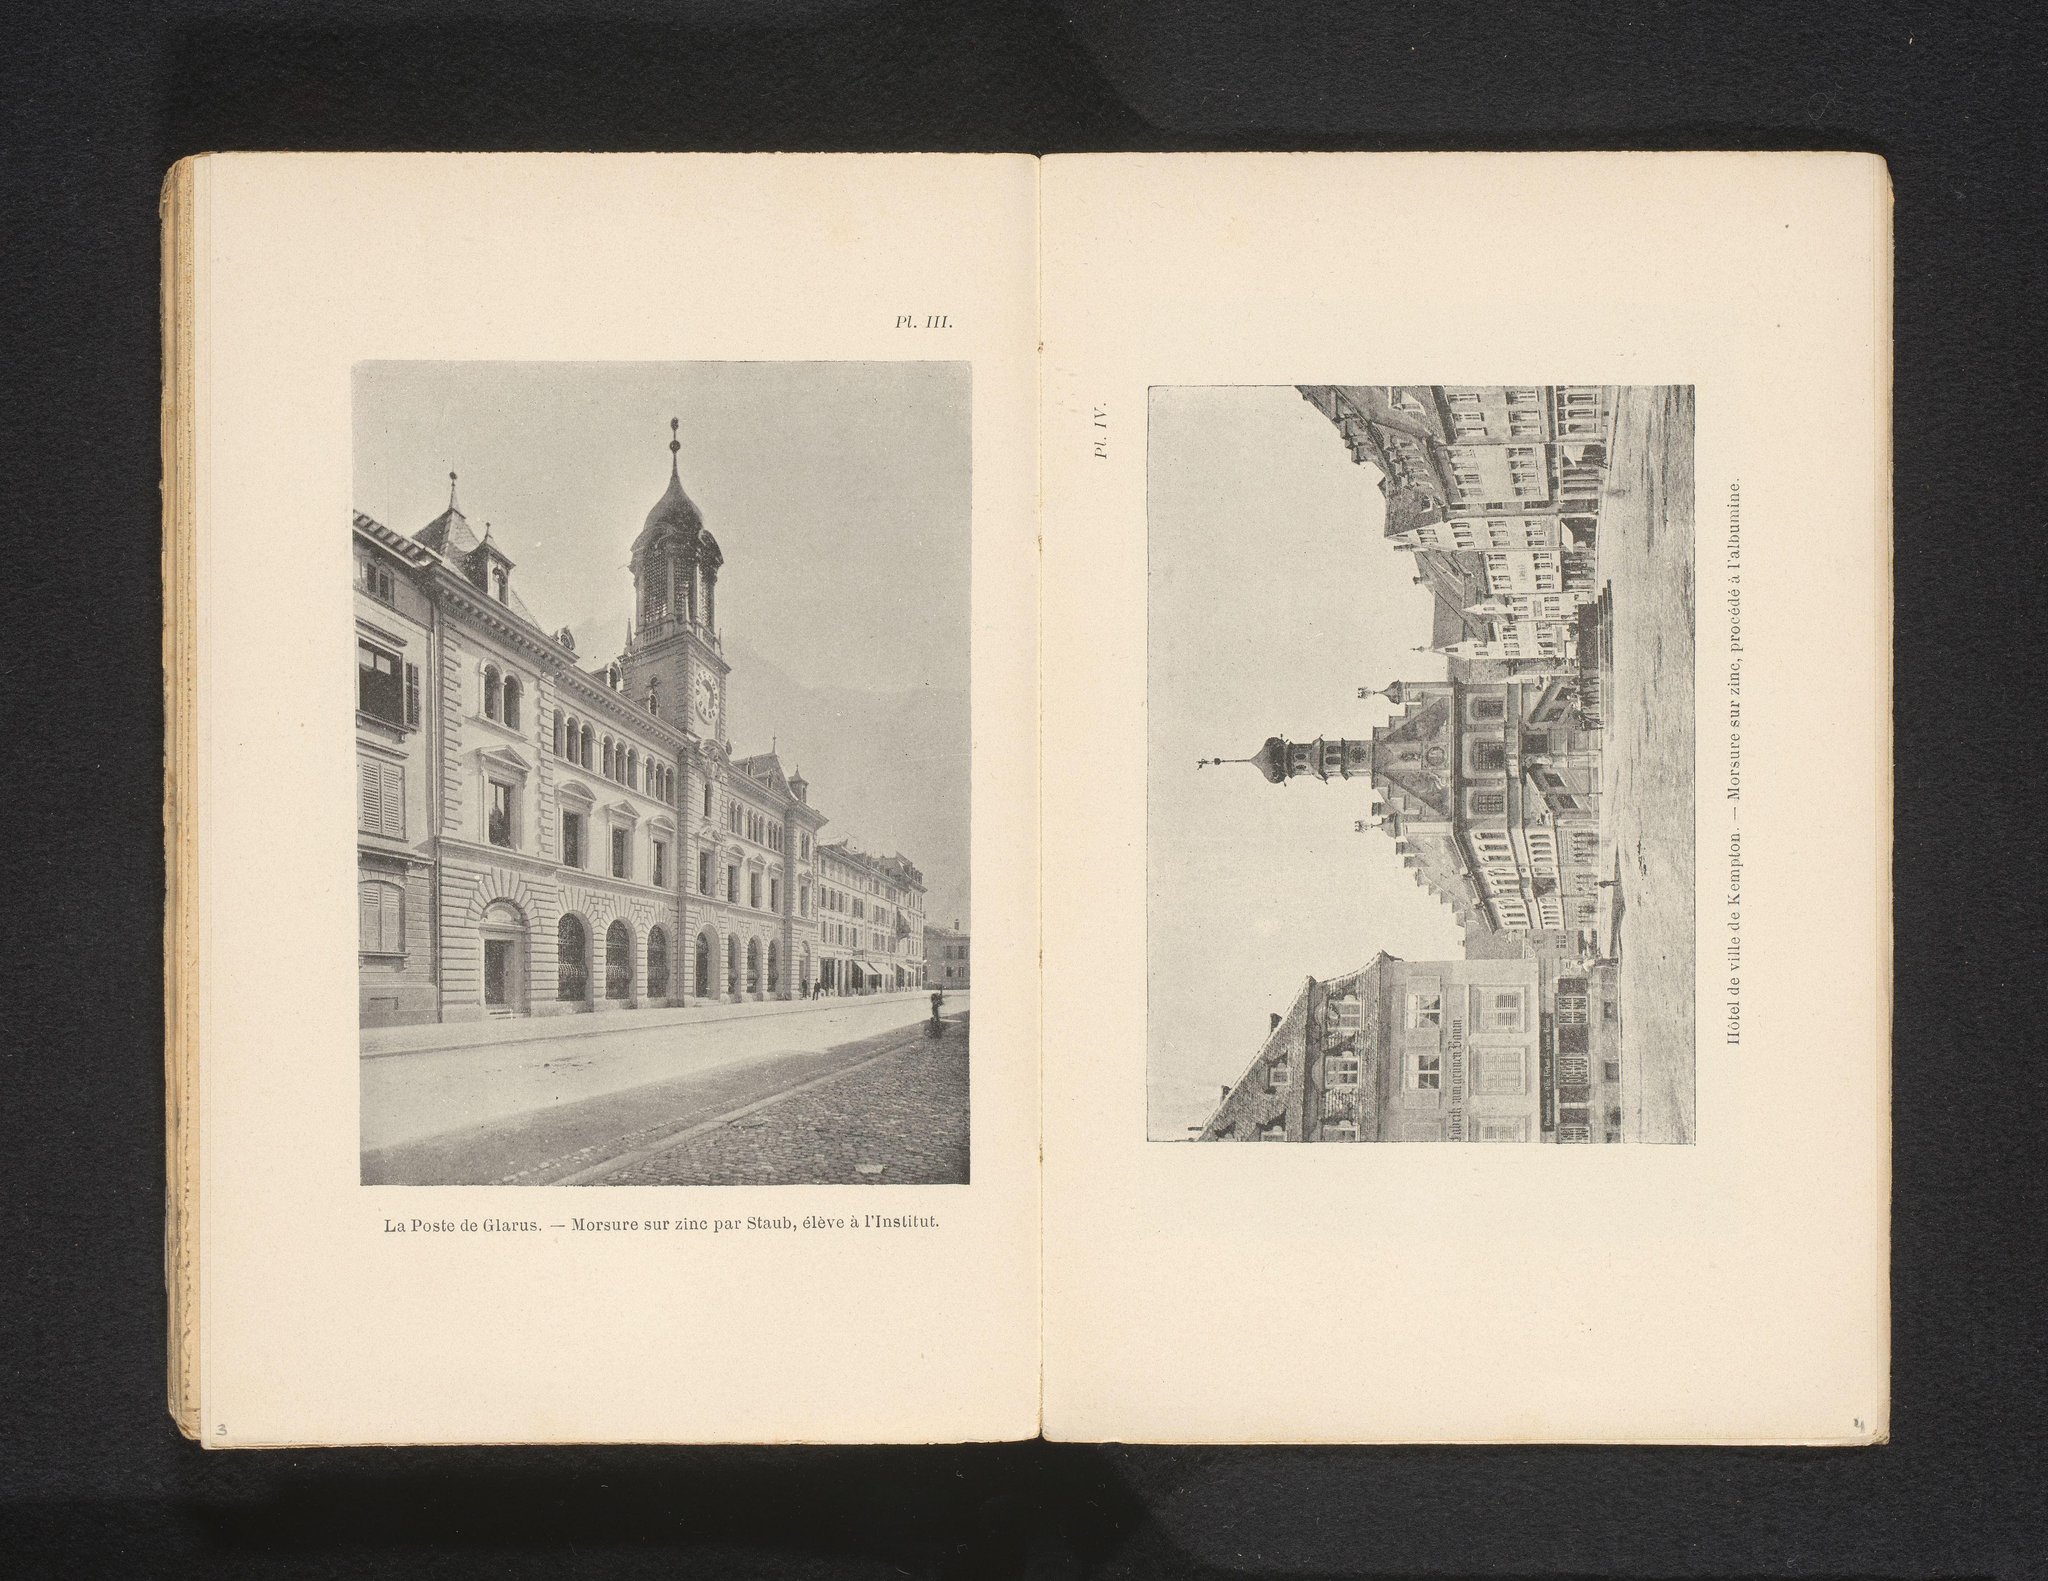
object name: photomechanical print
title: Hôtel de ville de Kempton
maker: Anonymous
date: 1888-1898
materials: paper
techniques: autotype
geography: switzerland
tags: townhall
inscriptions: number: ‘Pl. IV.’, inscription: ‘Morsure sur zinc, procédé à l'albumine.’